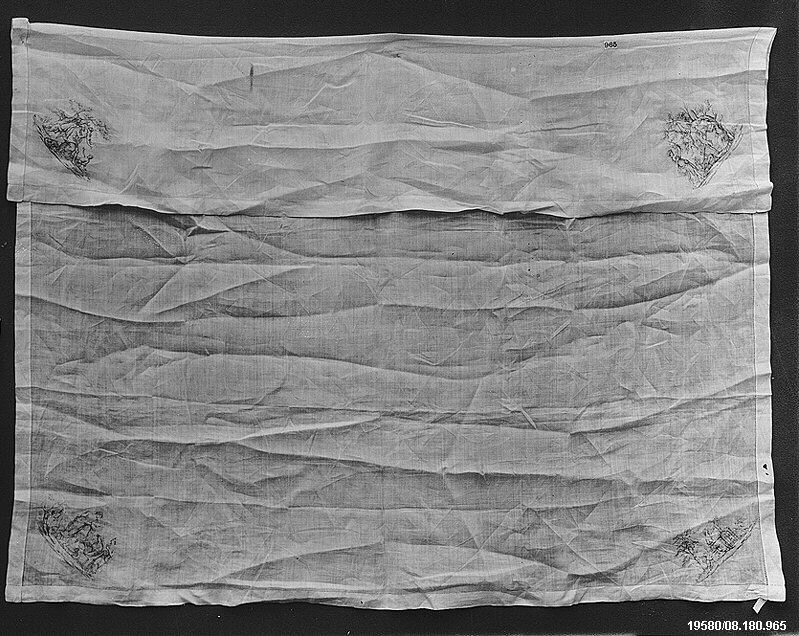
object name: handkerchief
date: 1801-1900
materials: linen